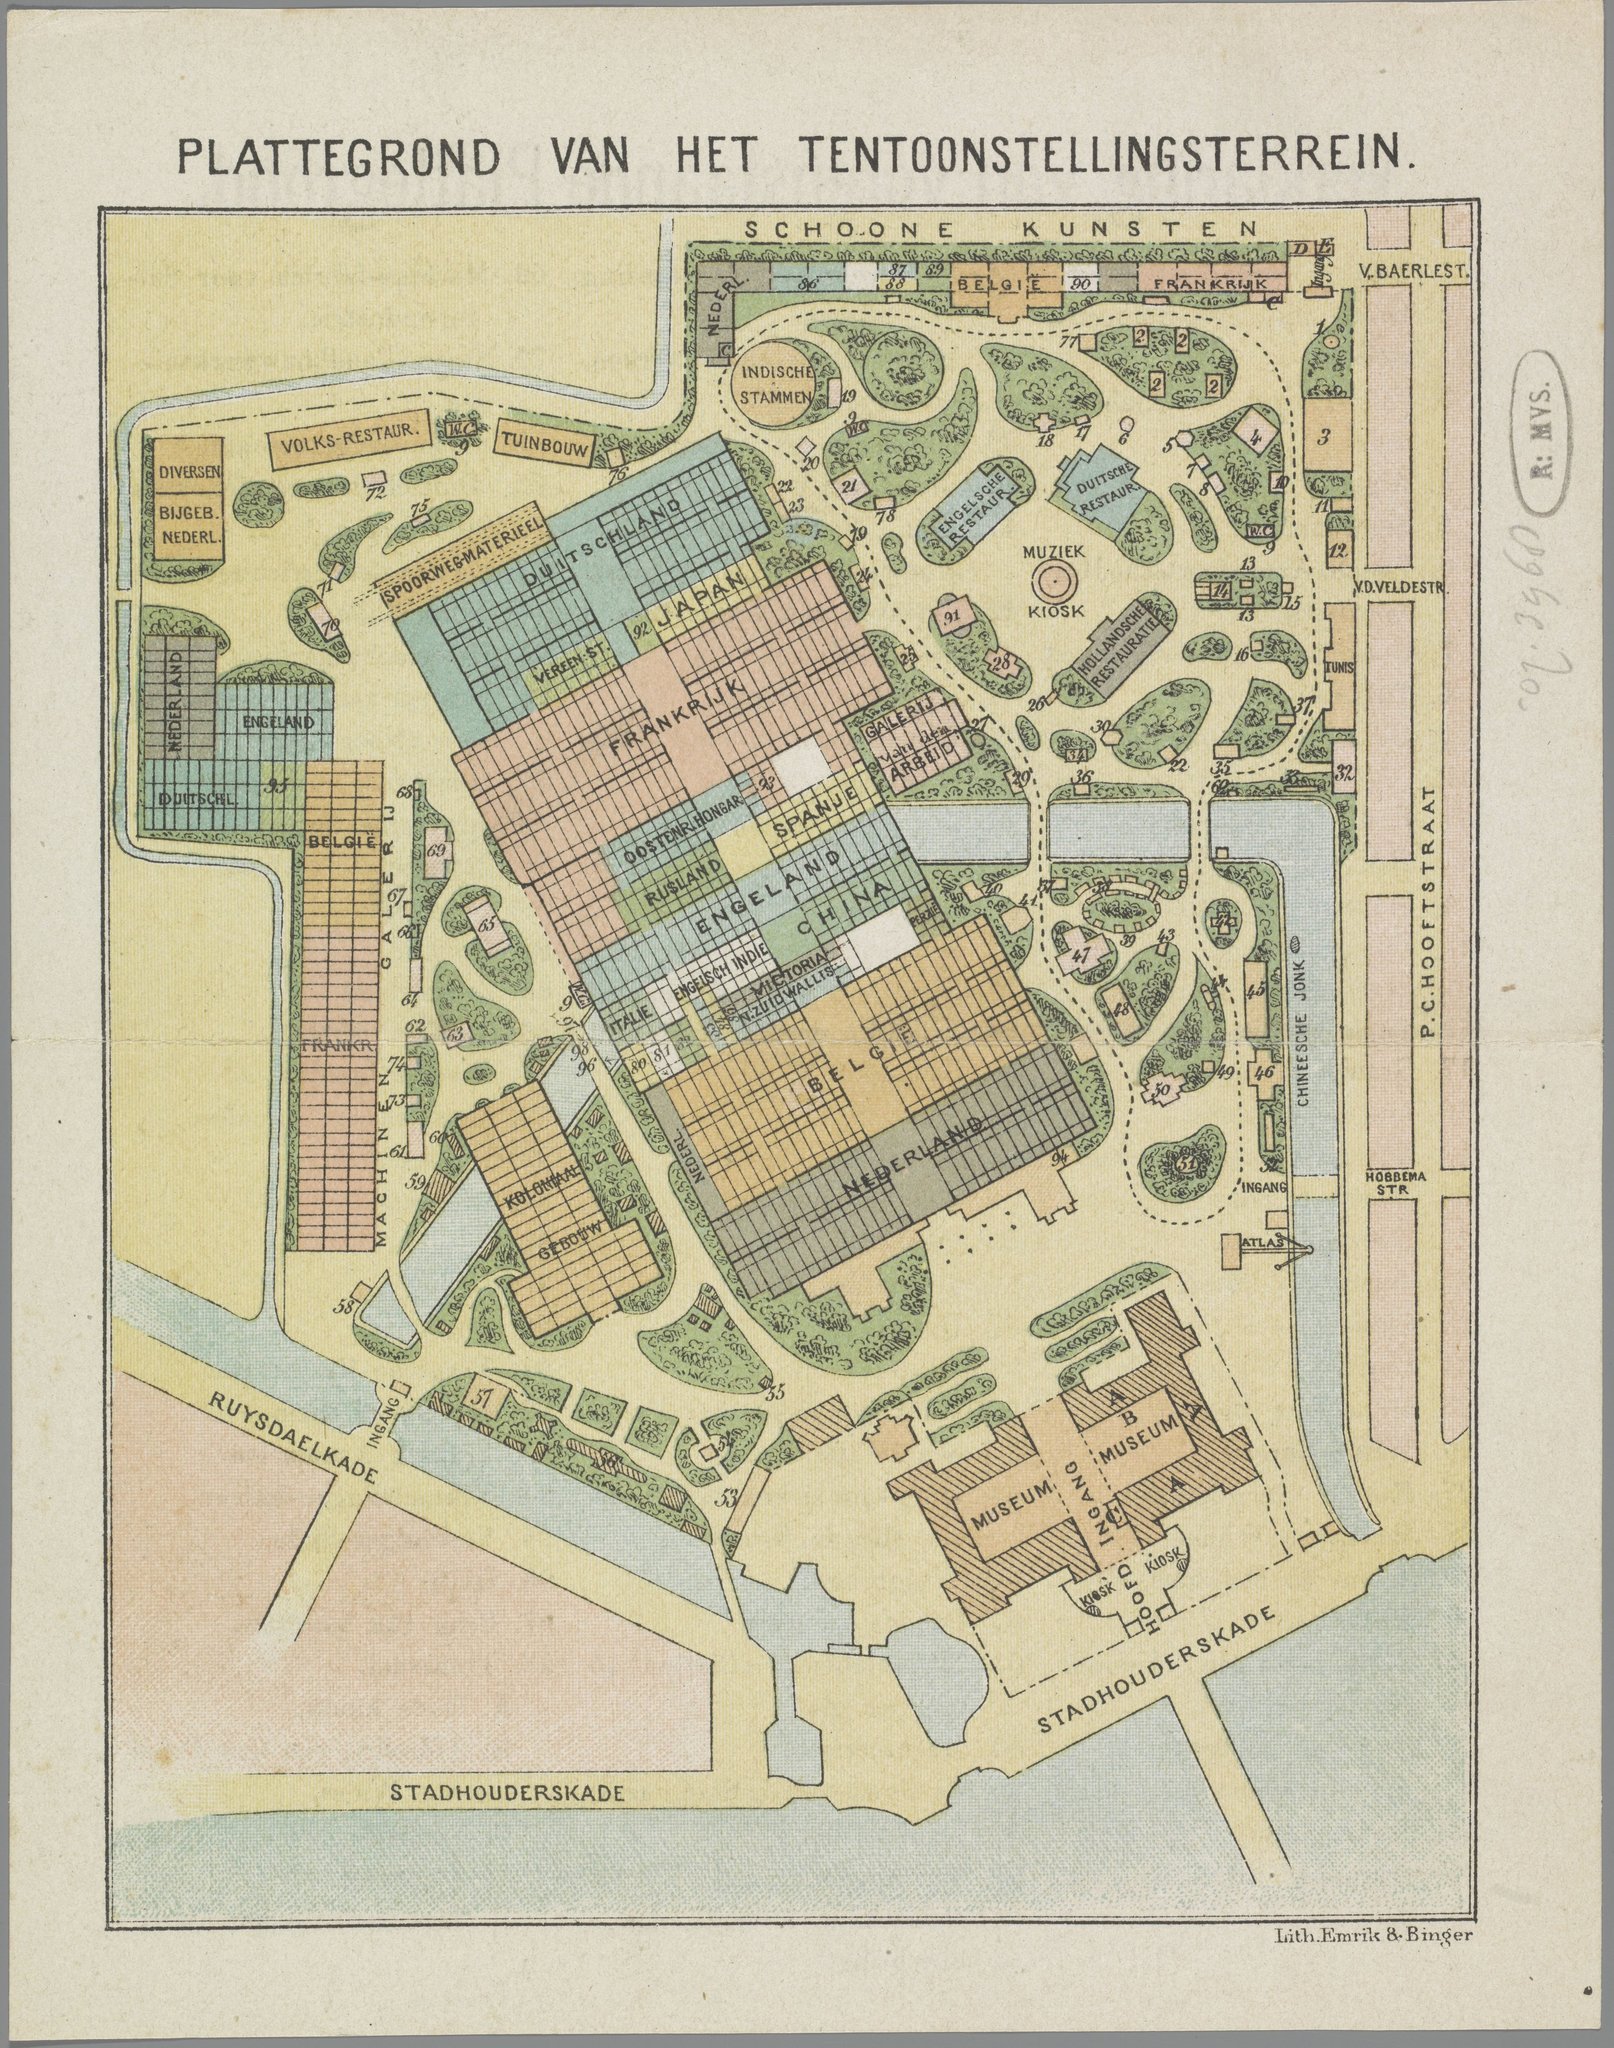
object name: print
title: Plattegrond van de Wereldtentoonstelling in Amsterdam, 1883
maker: Anonymous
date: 1883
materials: paper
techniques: chromolithography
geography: netherlands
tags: world fair, world exhibition, amsterdam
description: Plattegrond van het terrein van de Wereldtentoonstelling op het Museumplein te Amsterdam. Dubbelgevouwen blad, op de achterzijde de verklaring 1-98 en A-E. Onderdeel van een groep van zestien platen en een plattegrond van de Wereldtentoonstelling in Amsterdam van 1 mei tot 1 oktober 1883. Uitgave van het Nieuws van den Dag.